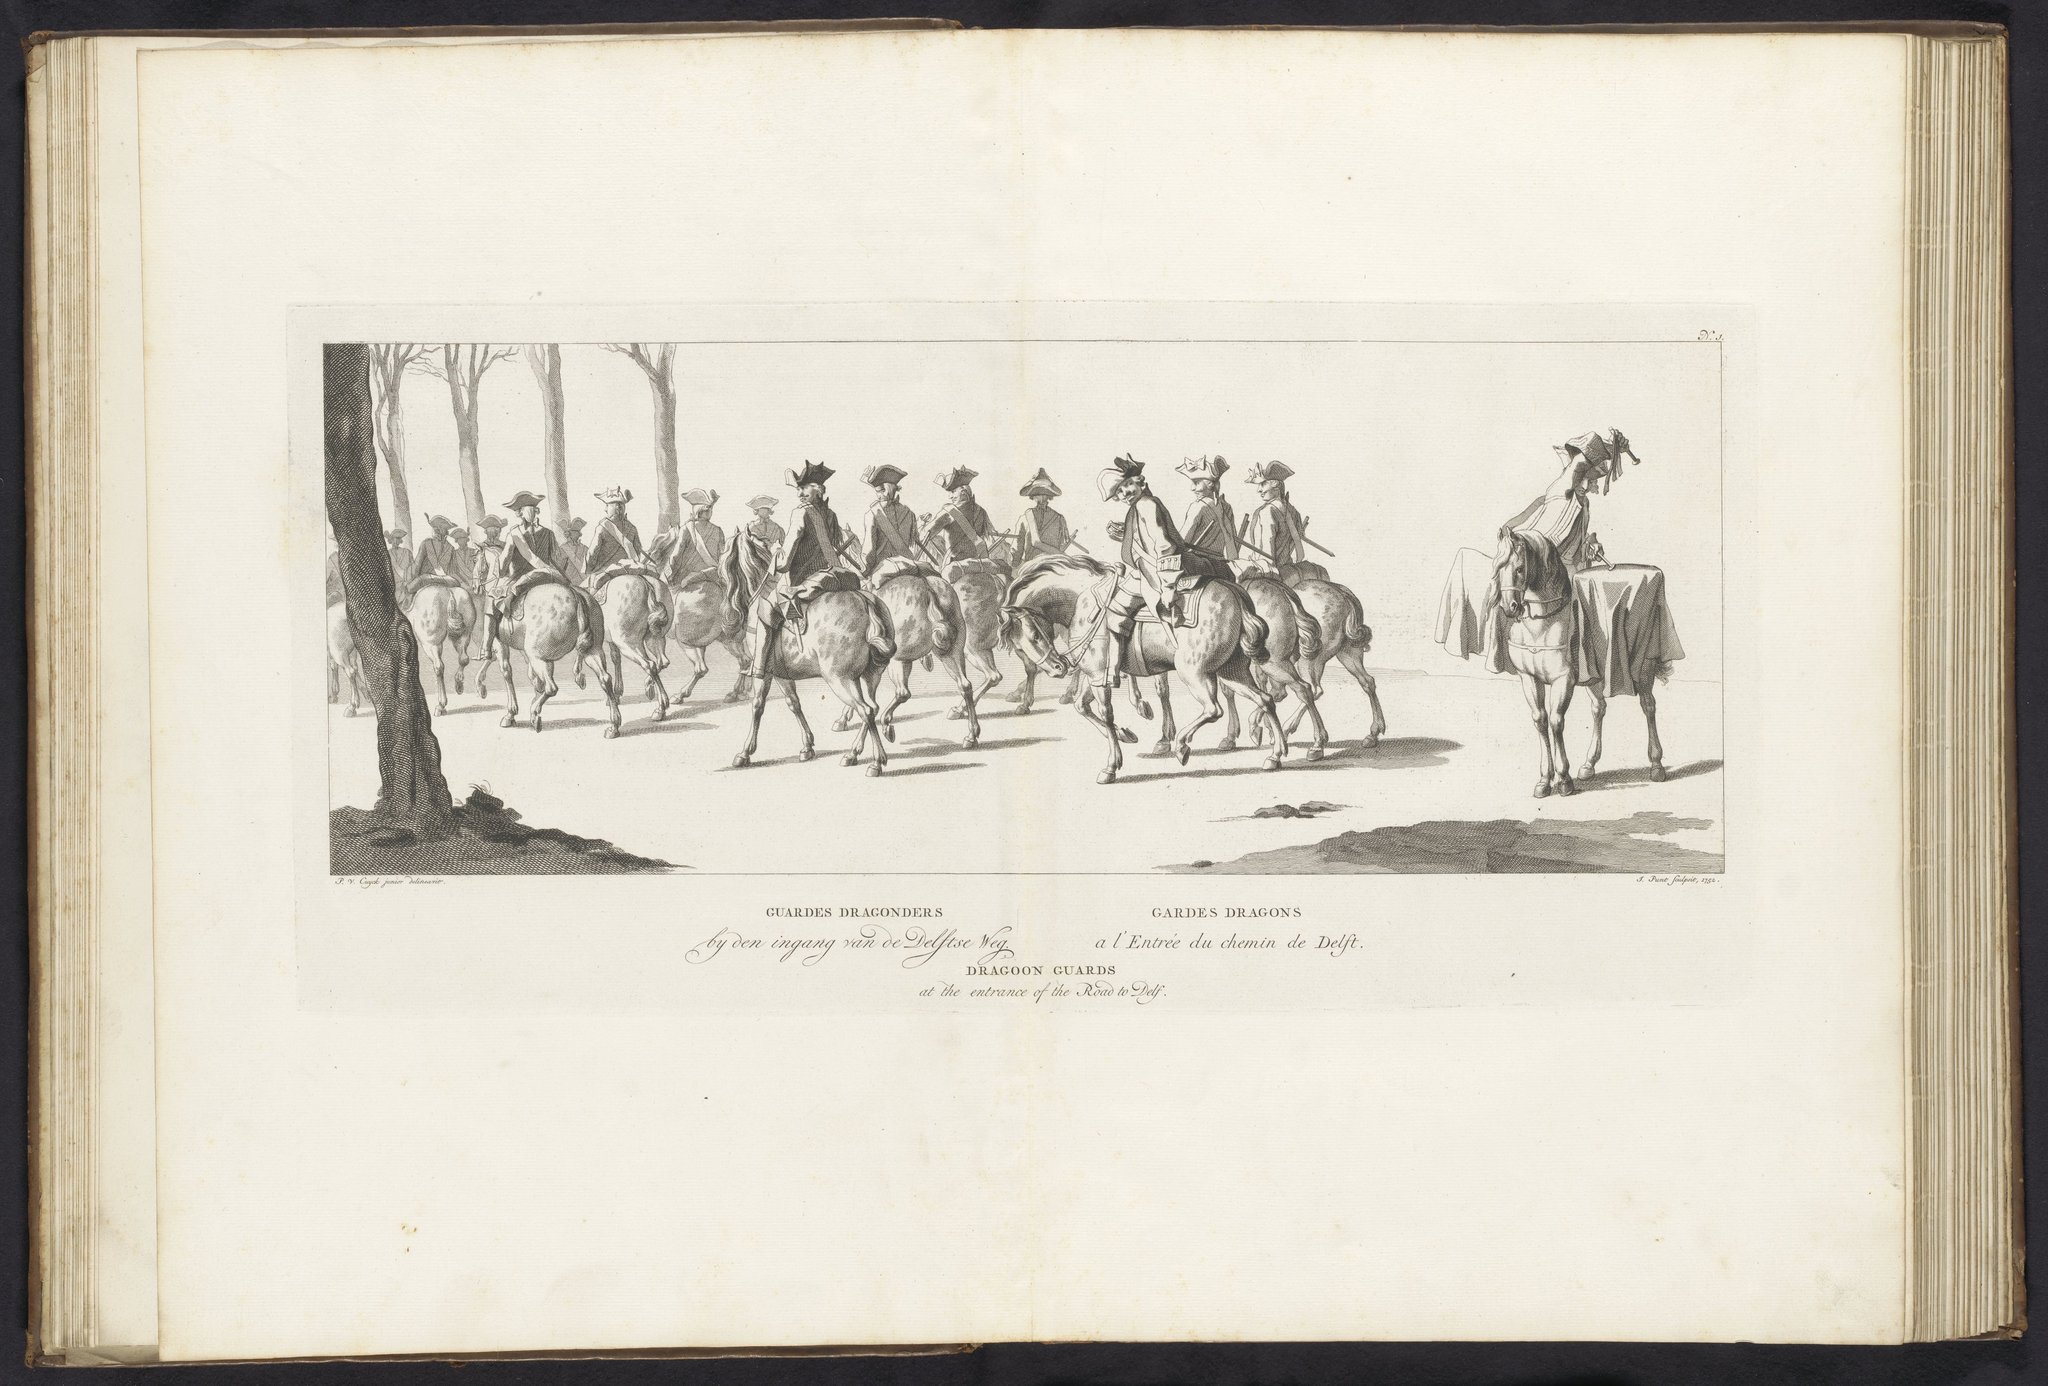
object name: print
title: Lyk-staetsie van zyne doorluchtigste Hoogheid den Heere Willem [IV] Carel Hendrik Friso, Prince van Orange en Nassau (...) gehouden den IV Februari 1752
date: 1752-1755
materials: paper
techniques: engraving, etching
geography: the hague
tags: the hague, willem iv (prins van oranje-nassau), military parade, pageant (+ cavalry, horsemen), cortege, funeral procession, delft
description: Dragonders en een trommelslager. In de marge het onderschrift in Nederlands, Frans en Engels. Onderdeel van een serie van 41 platen van de begrafenisstoet van stadhouder Willem IV te Delft op 4 februari 1752. Genummerd rechtsboven: N. 1. In de gebonden uitgave van 1755.